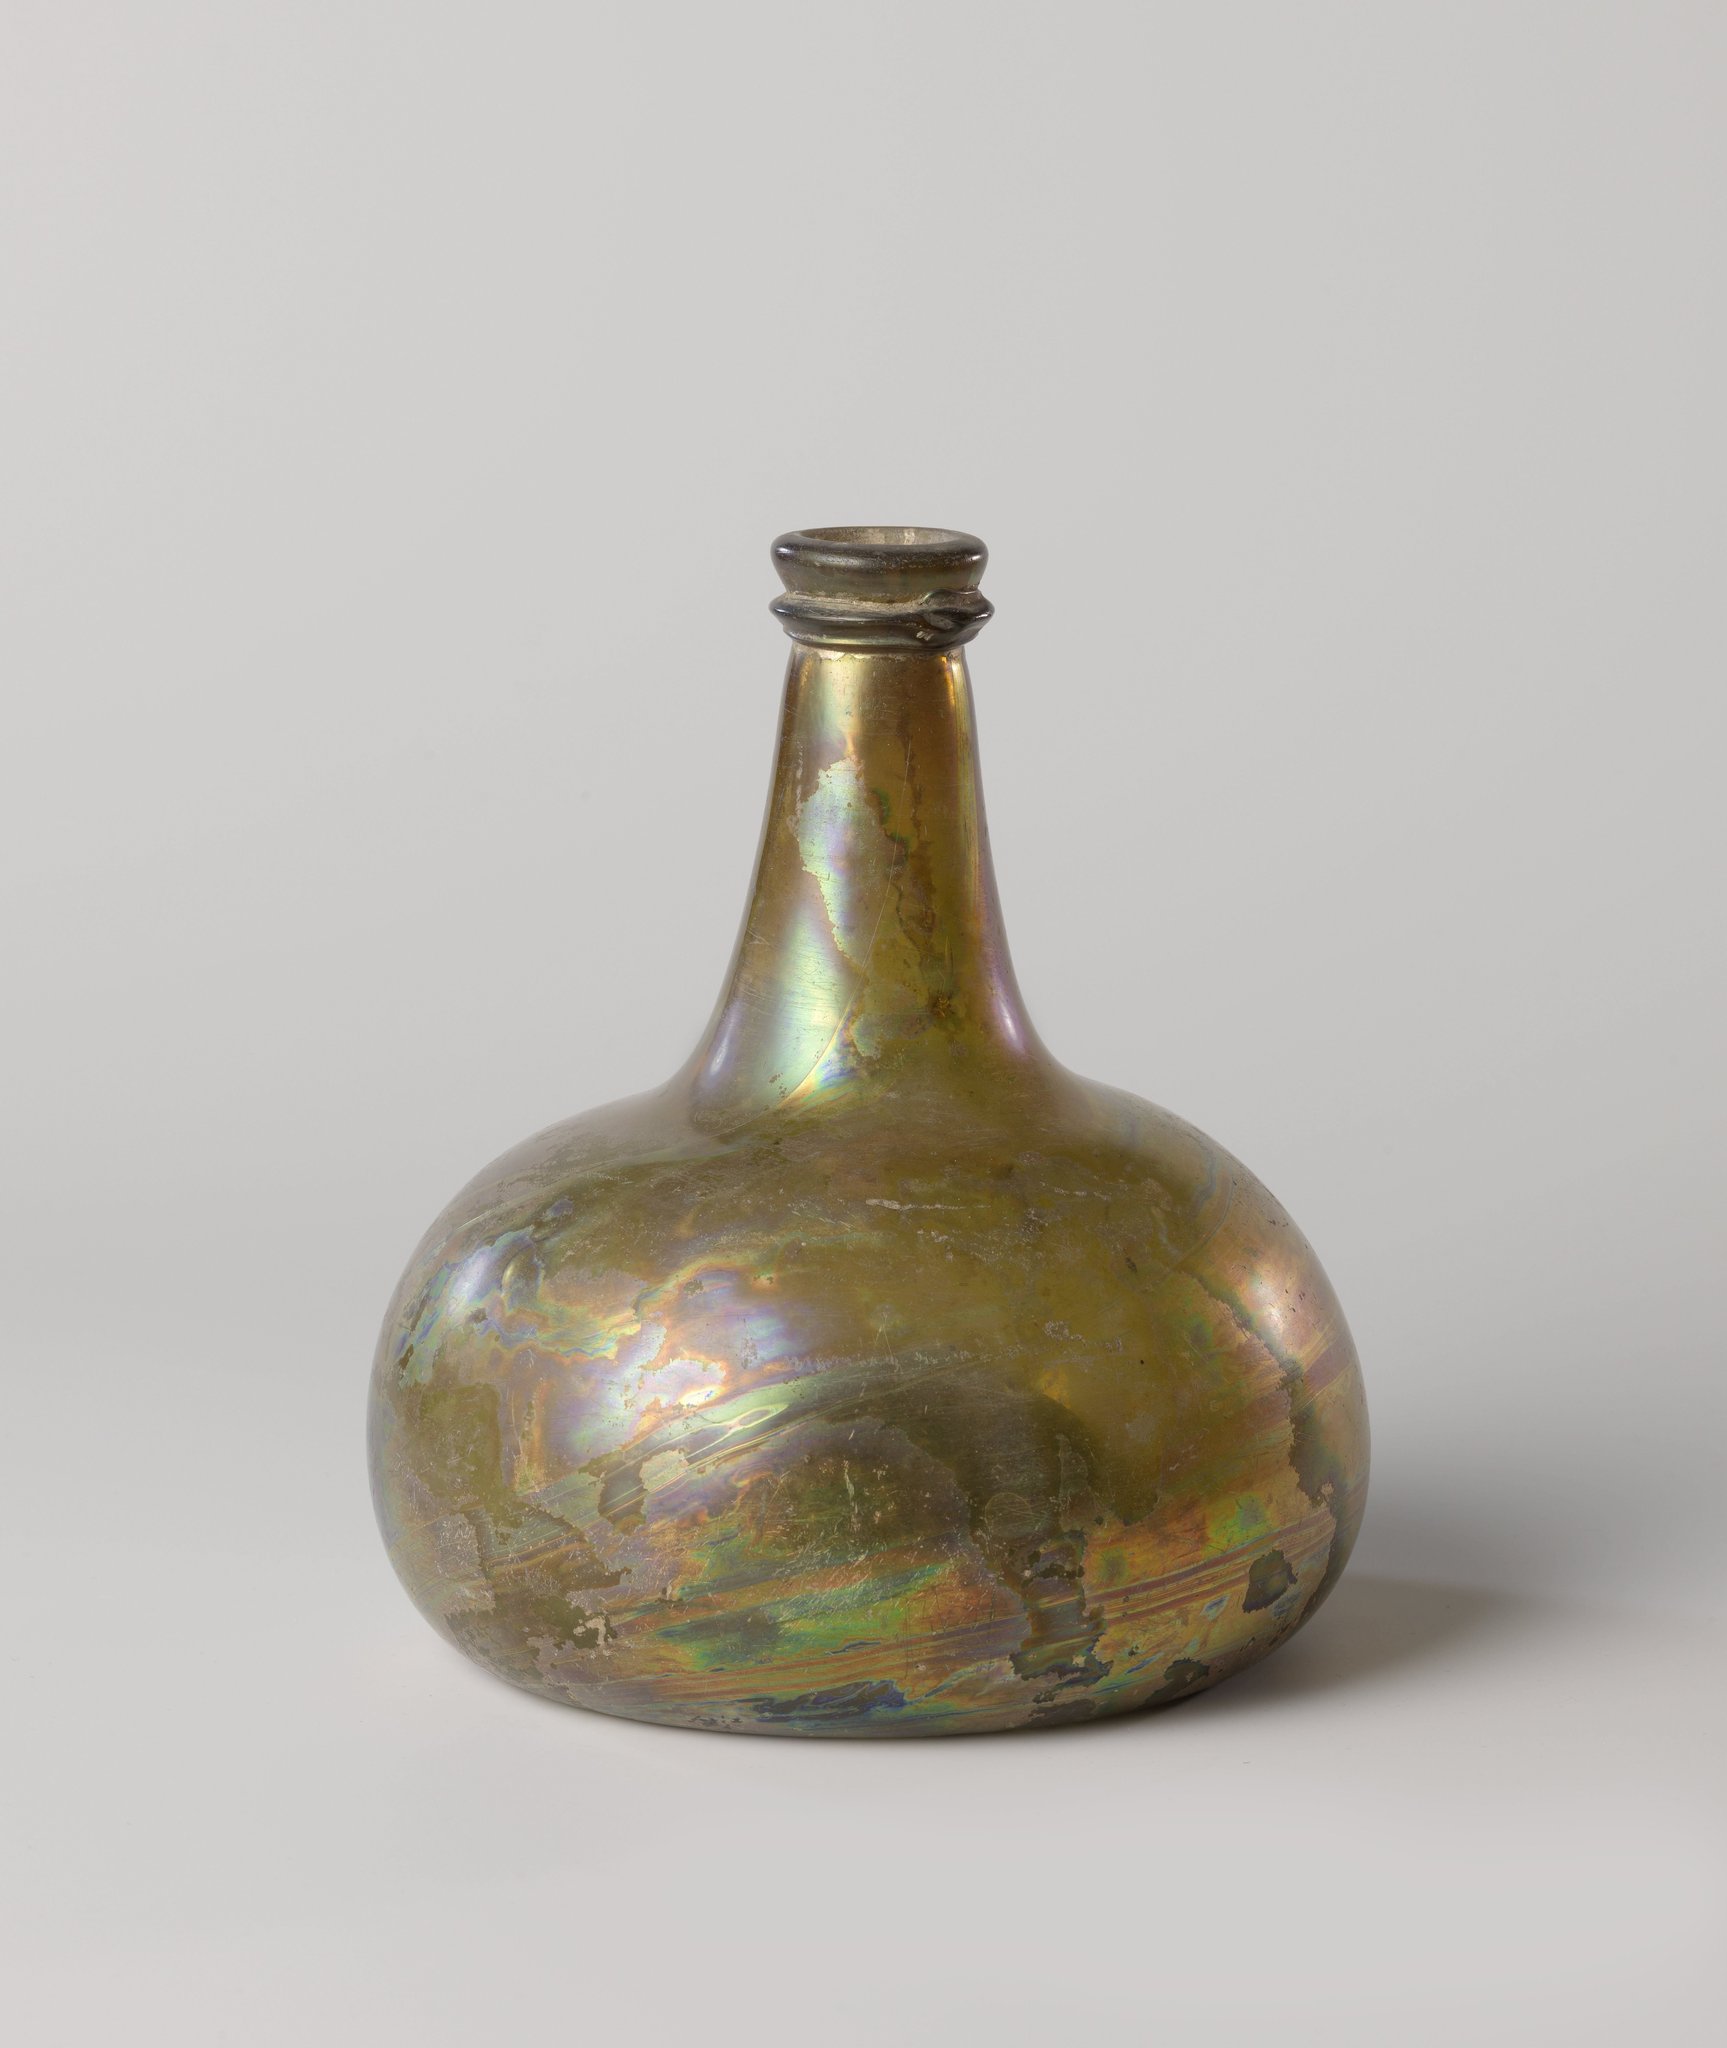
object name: bottle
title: Fles met bolvormig lichaam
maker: Anonymous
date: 1700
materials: glass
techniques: glassblowing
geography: northwest europe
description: Ingestoken ziel, licht afgeplat bolvormig lichaam, overgaand in een korte, toelopende hals met een hooggeplaatste ring.